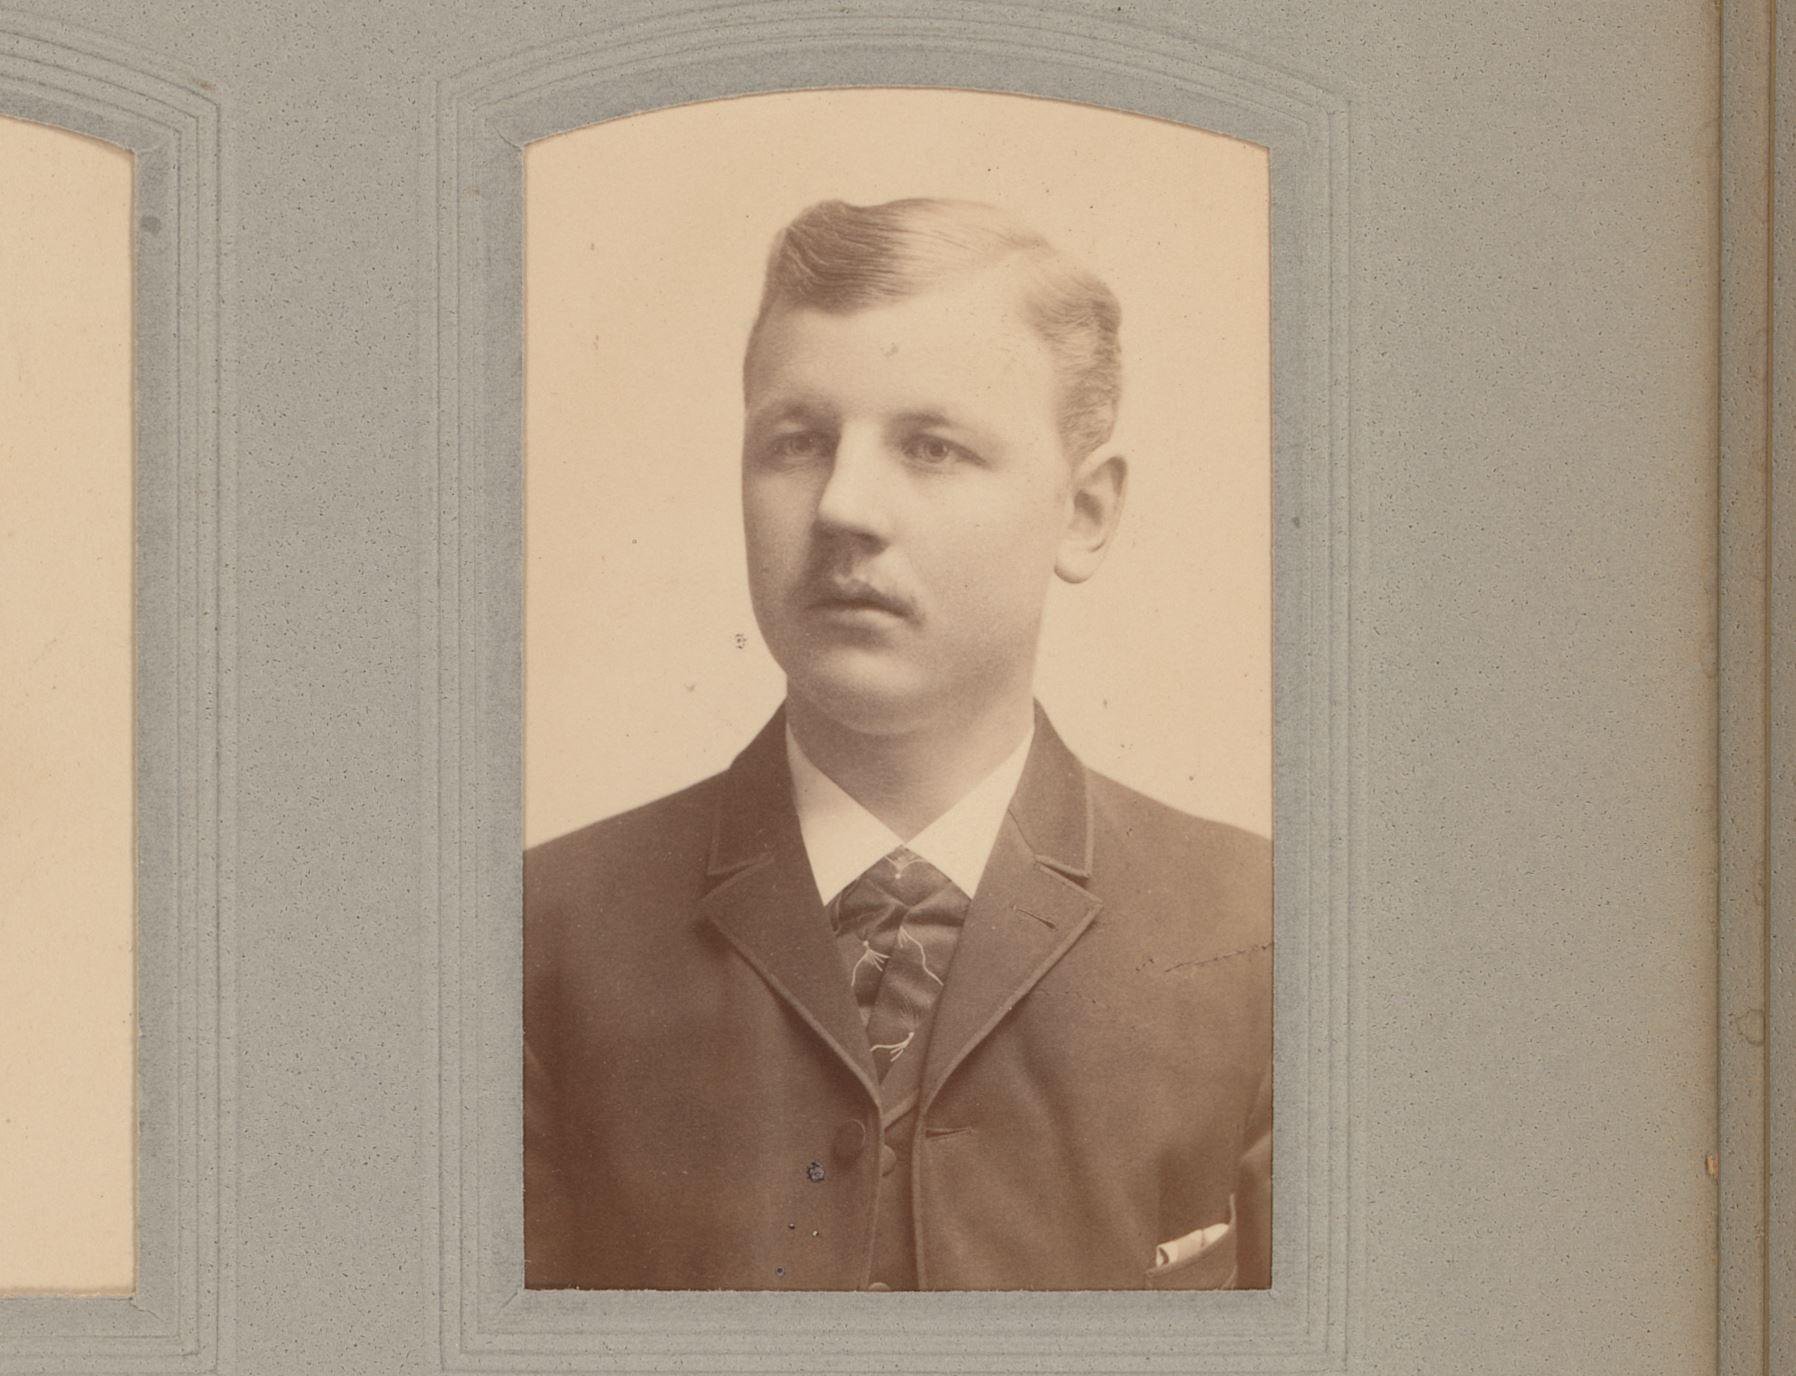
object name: photograph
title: Portret van een jonge man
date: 1860-1900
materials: cardboard, photographic support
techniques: albumen print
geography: helsinki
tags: historical persons, youth, adolescent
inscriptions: inscription: ‘Skilnadens/ Atelier/ HELSINGFORS/ Ludvigsgatan No. 7./ Plåten förvaras för efterbeställning.’